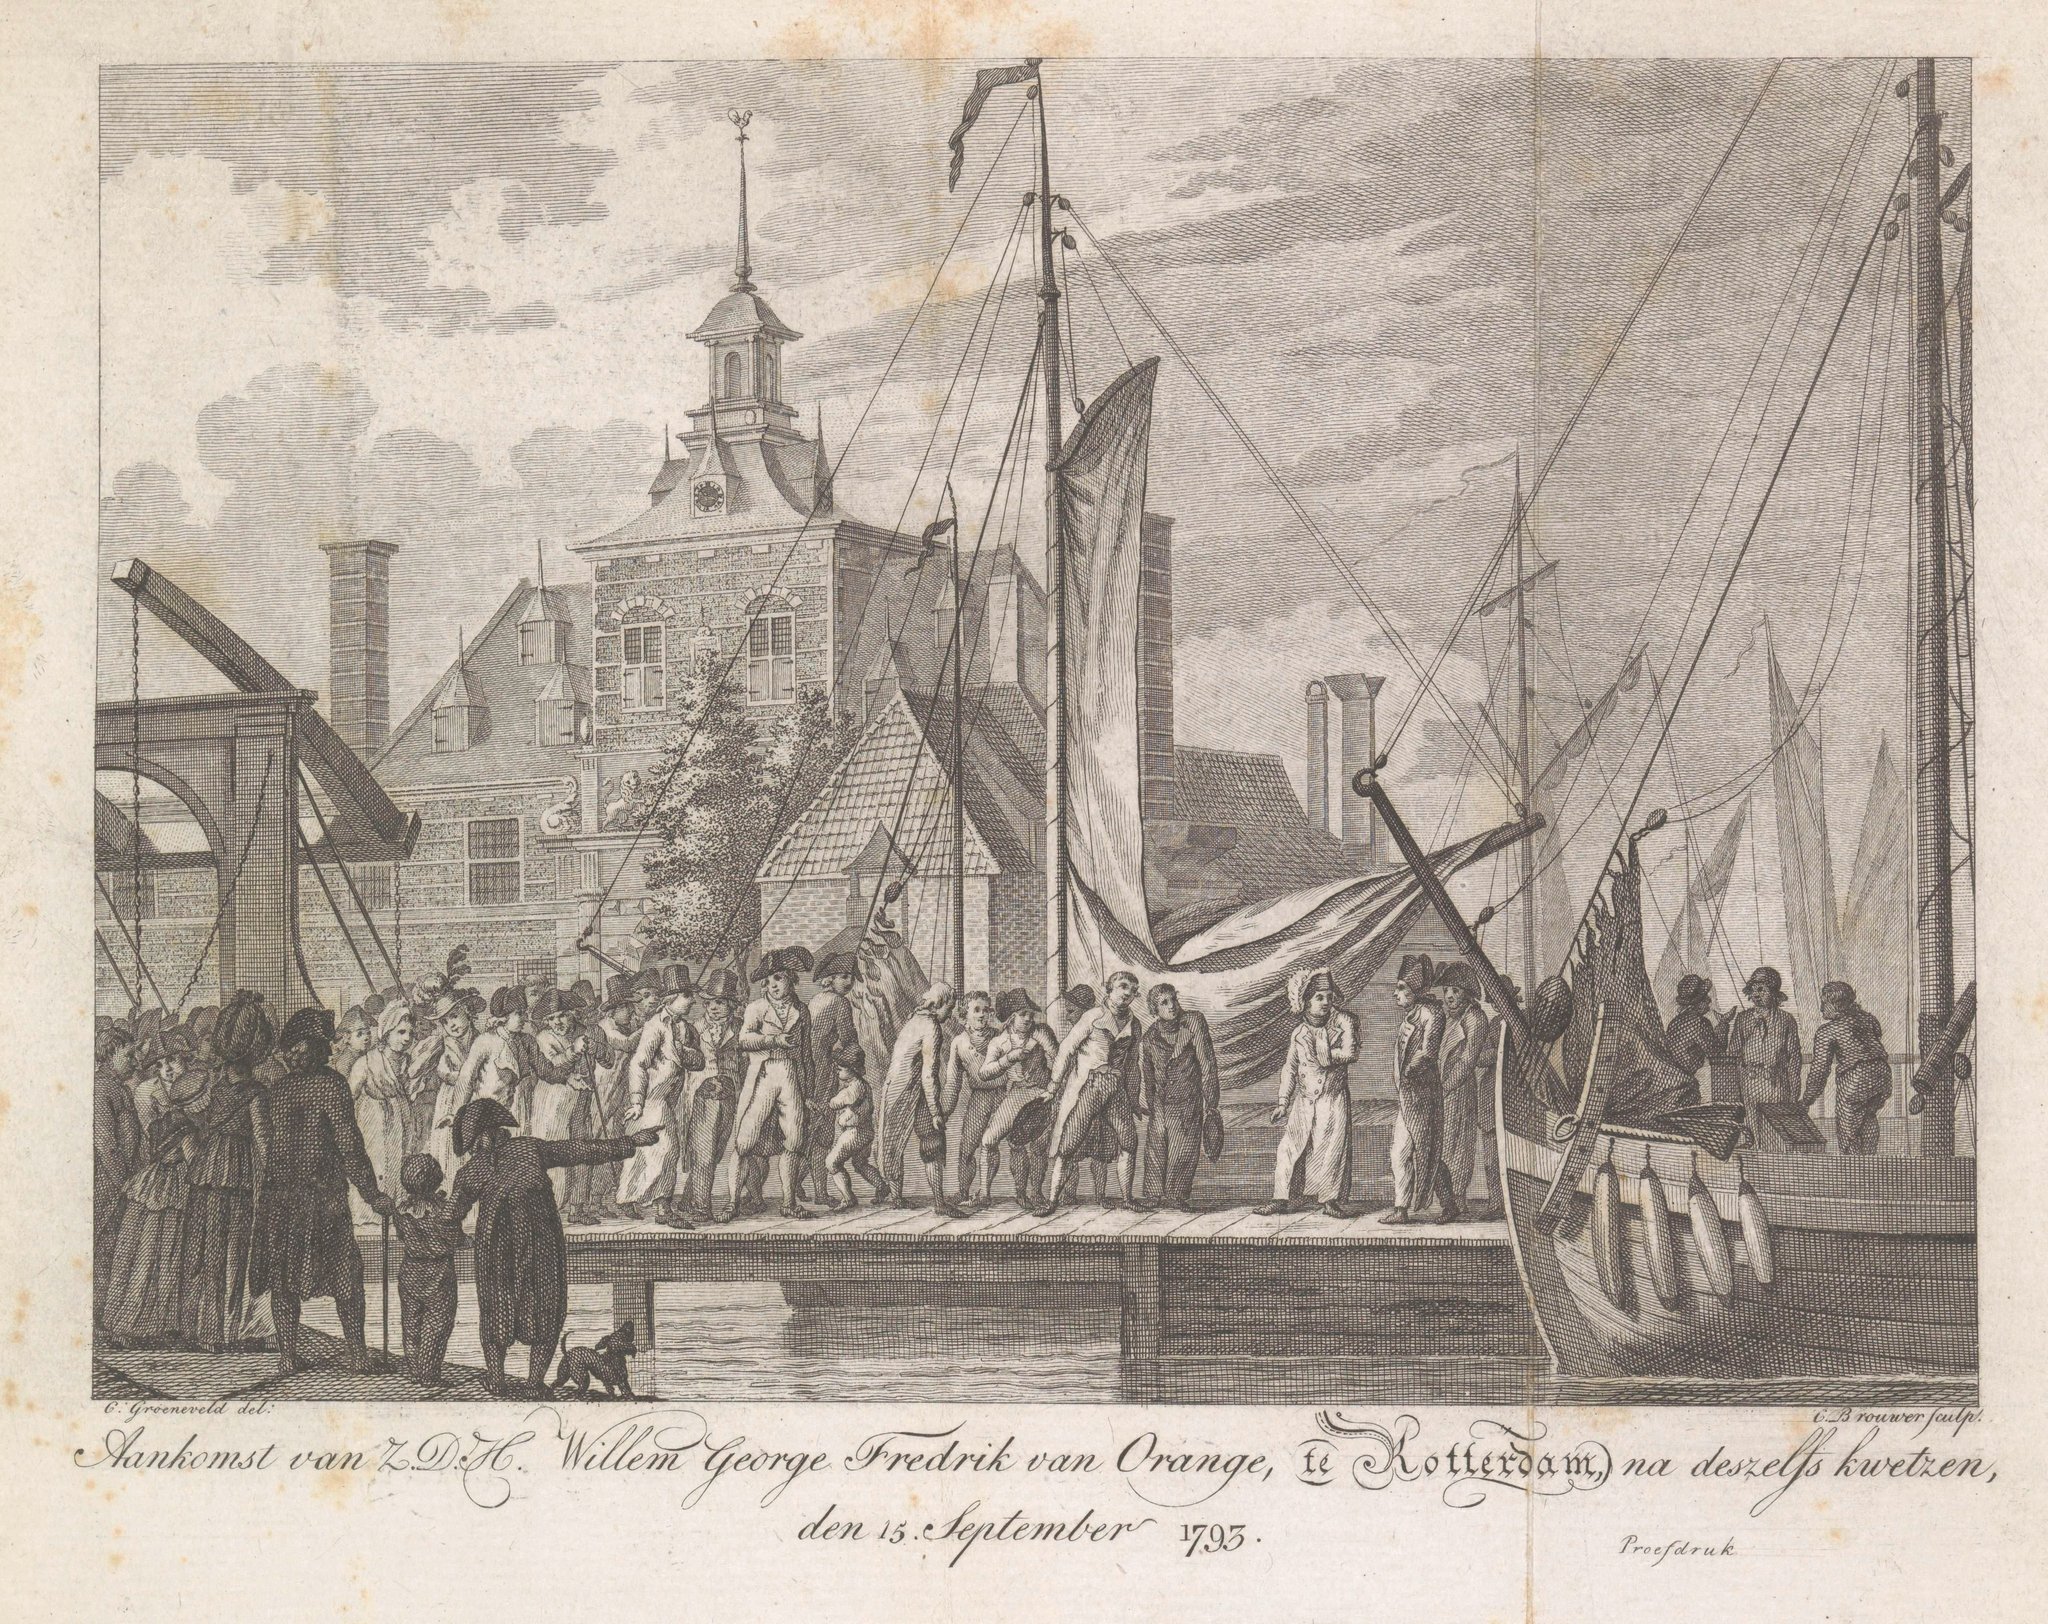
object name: history print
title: Aankomst de gewonde prins Willem George Frederik te Rotterdam, 1793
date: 1802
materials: paper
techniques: engraving, etching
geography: rotterdam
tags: the hague, willem george frederik (prins van oranje-nassau), battle (+ land forces), rotterdam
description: Aankomst van Willem George Frederik, prins van Oranje-Nassau, te Rotterdam op 15 september na zijn verwonding op 13 september 1793 tijdens de slag bij Wervik. De prins loopt over de steiger waar veel publiek staat, op de achtergrond de Hoofdpoort. Illustratie in het vierdelige Leven van Willem George Fredrik (1802-1803).